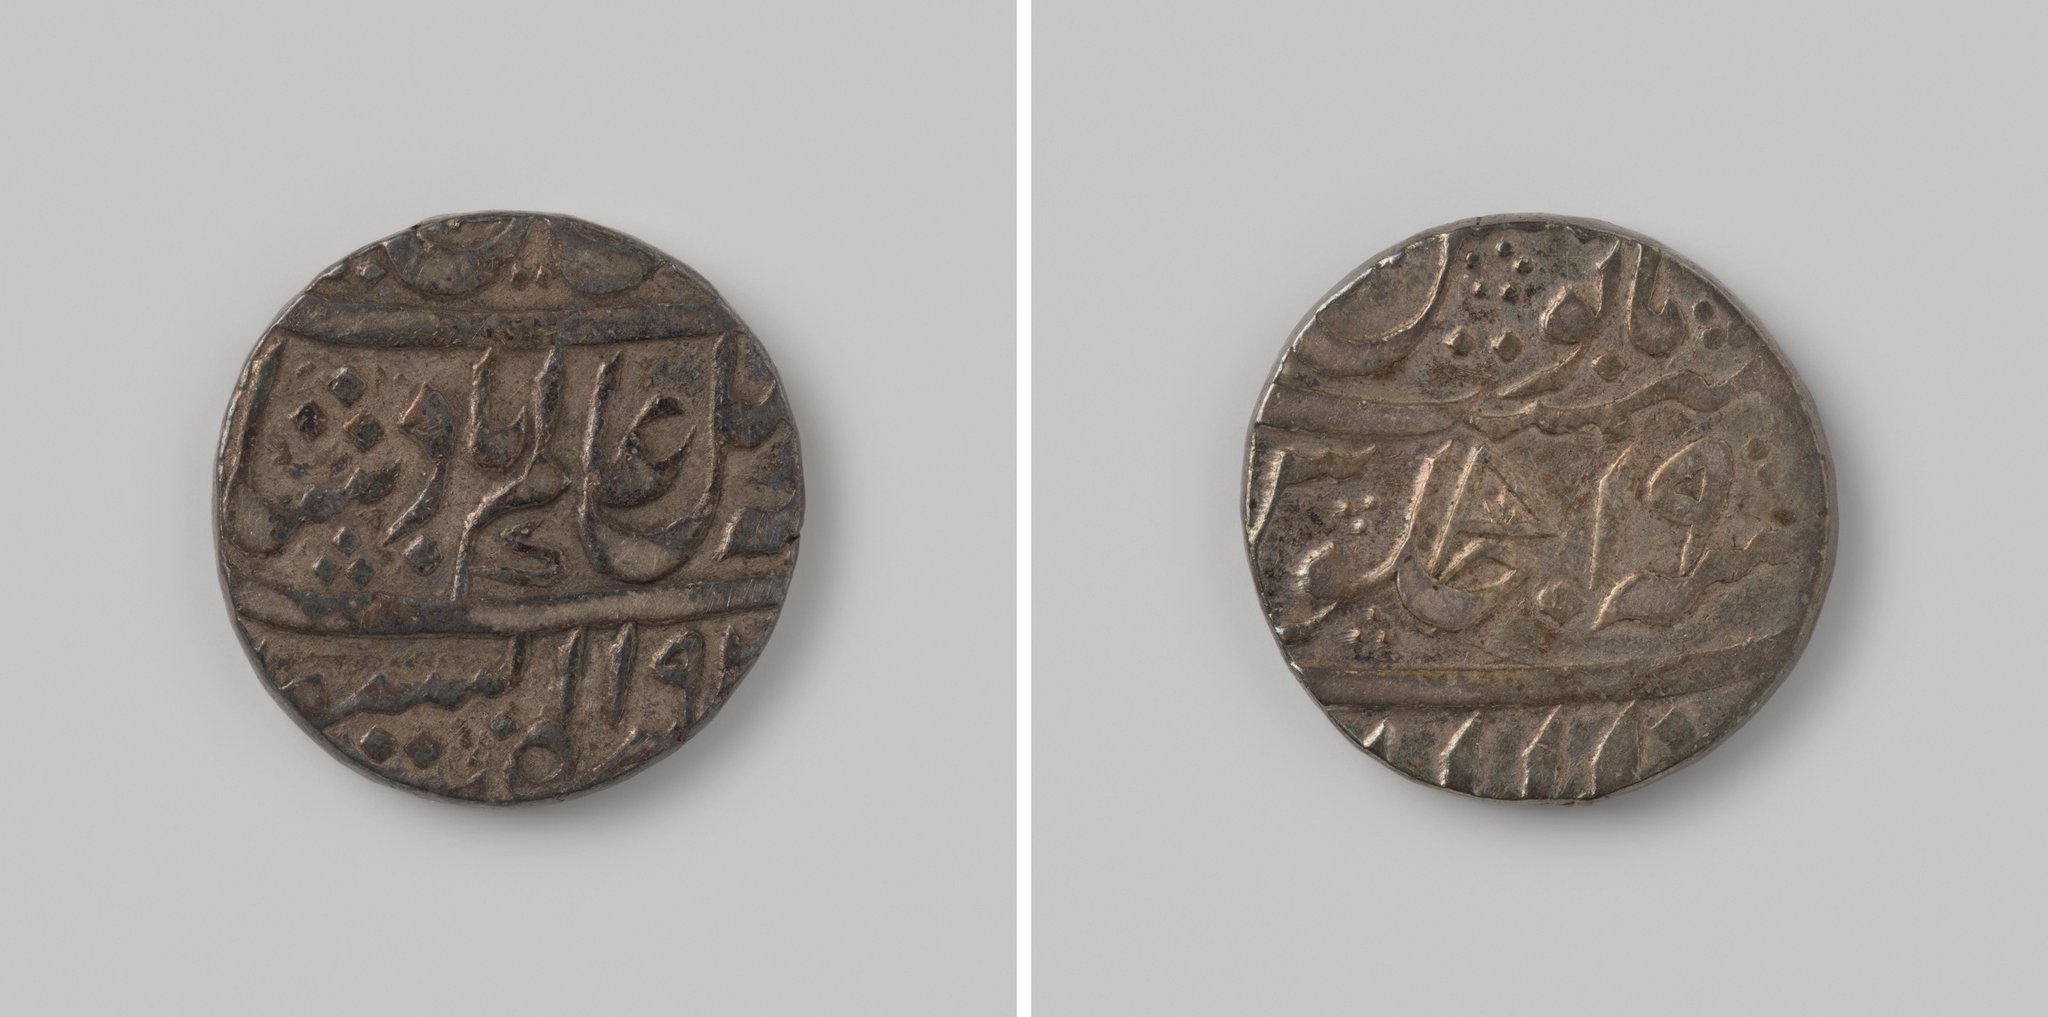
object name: coin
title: Roepie uit Bengalen in India van de Engelse Oostindische Compagnie (EIC) op naam van Sjah Alam I,1192 [=1779]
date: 1779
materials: silver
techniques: striking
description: Zilveren munt. Voorzijde: in Arabische lettertekens in drie regels opschrift. Keerzijde: in Arabische lettertekens in drie regels opschrift. Boven tweede regel aanduiding van het regeringsjaar: 19. Geslagen te Banares [?]. Gladde rand.